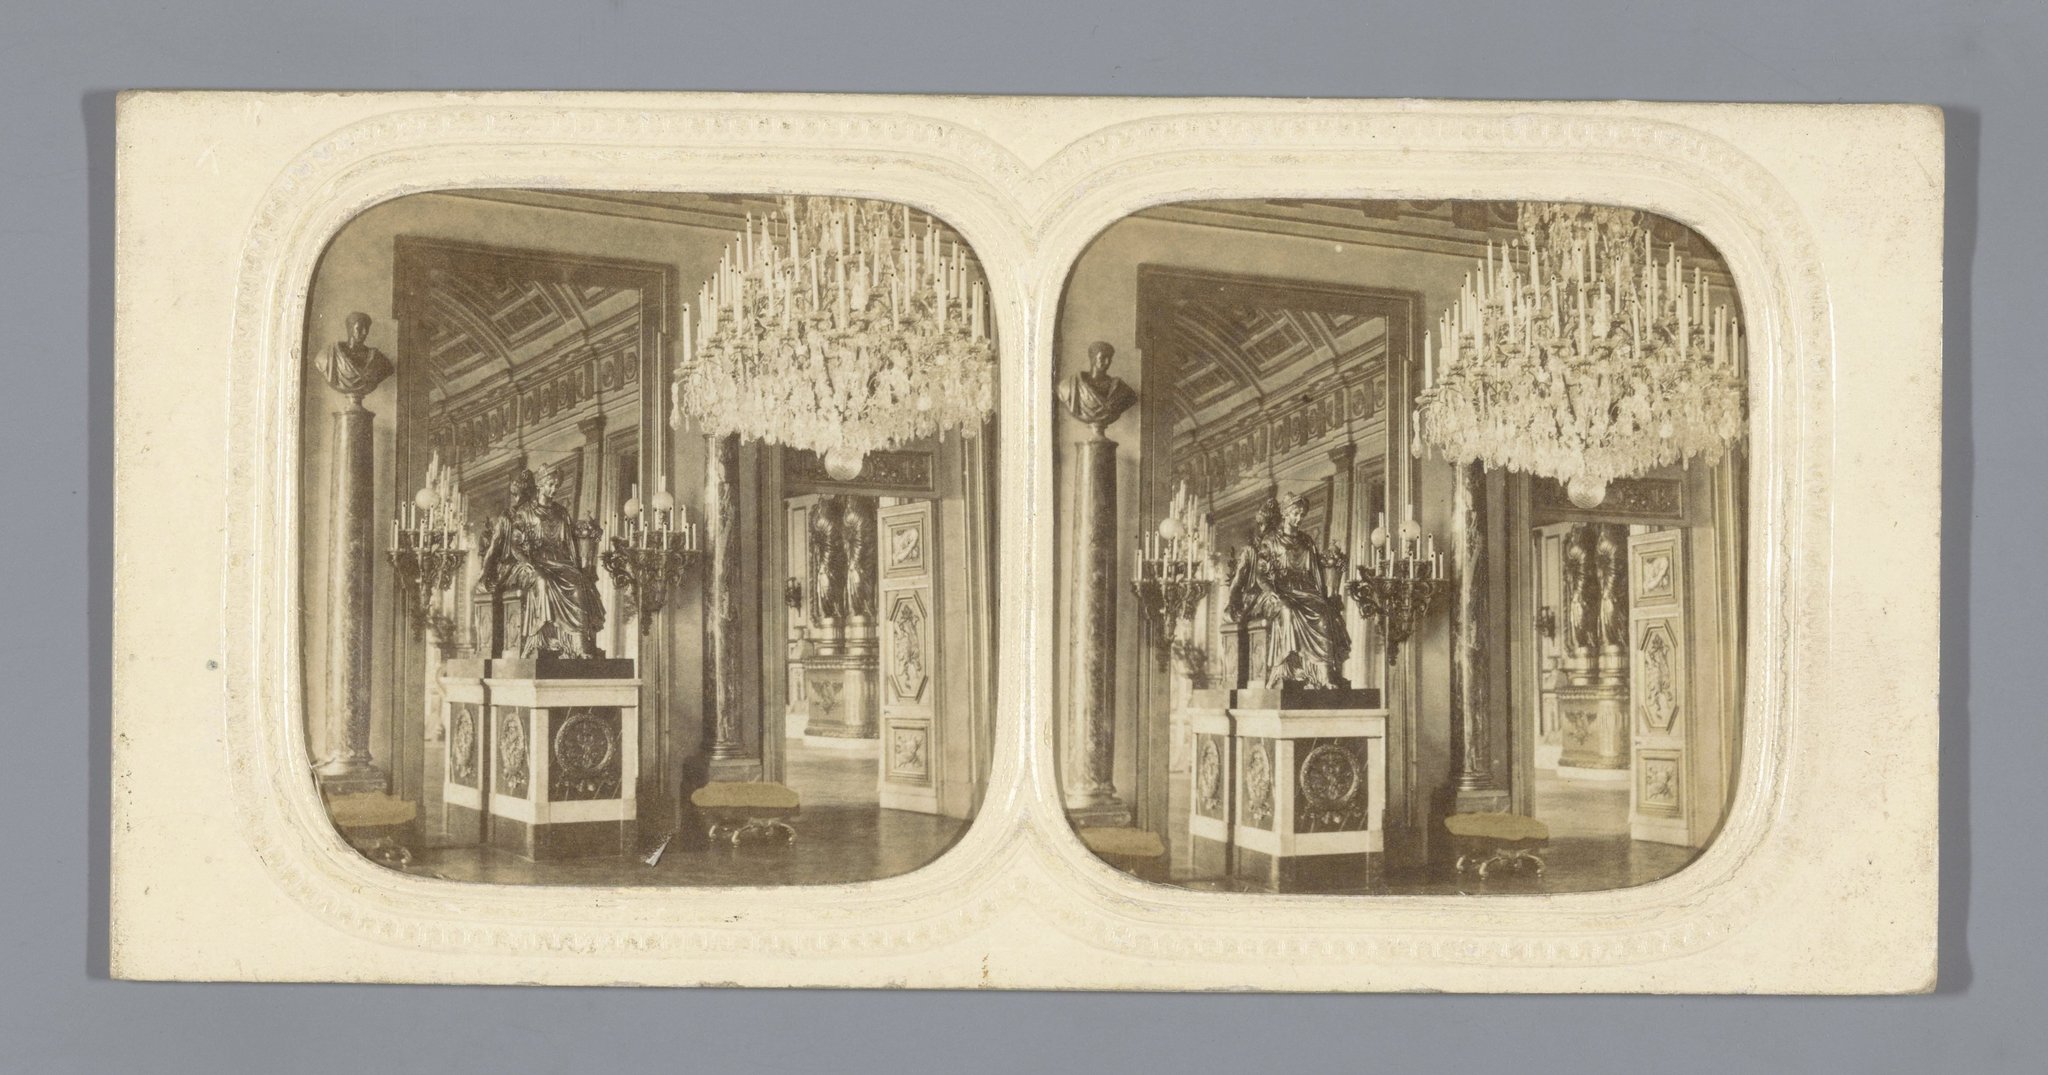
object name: tissue stereograph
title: Allegorisch beeld van de vrede in de Salon de la Paix in het Tuilerieënpaleis, Parijs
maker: Anonymous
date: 1855-1871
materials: cardboard, paper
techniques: albumen print, hand coloring, perforating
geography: paris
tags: palace - aa - civic architecture: inside, symbols, allegories of peace, 'pax'; 'pace' (ripa), tuileries palace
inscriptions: number: ‘75’, number: ‘24’